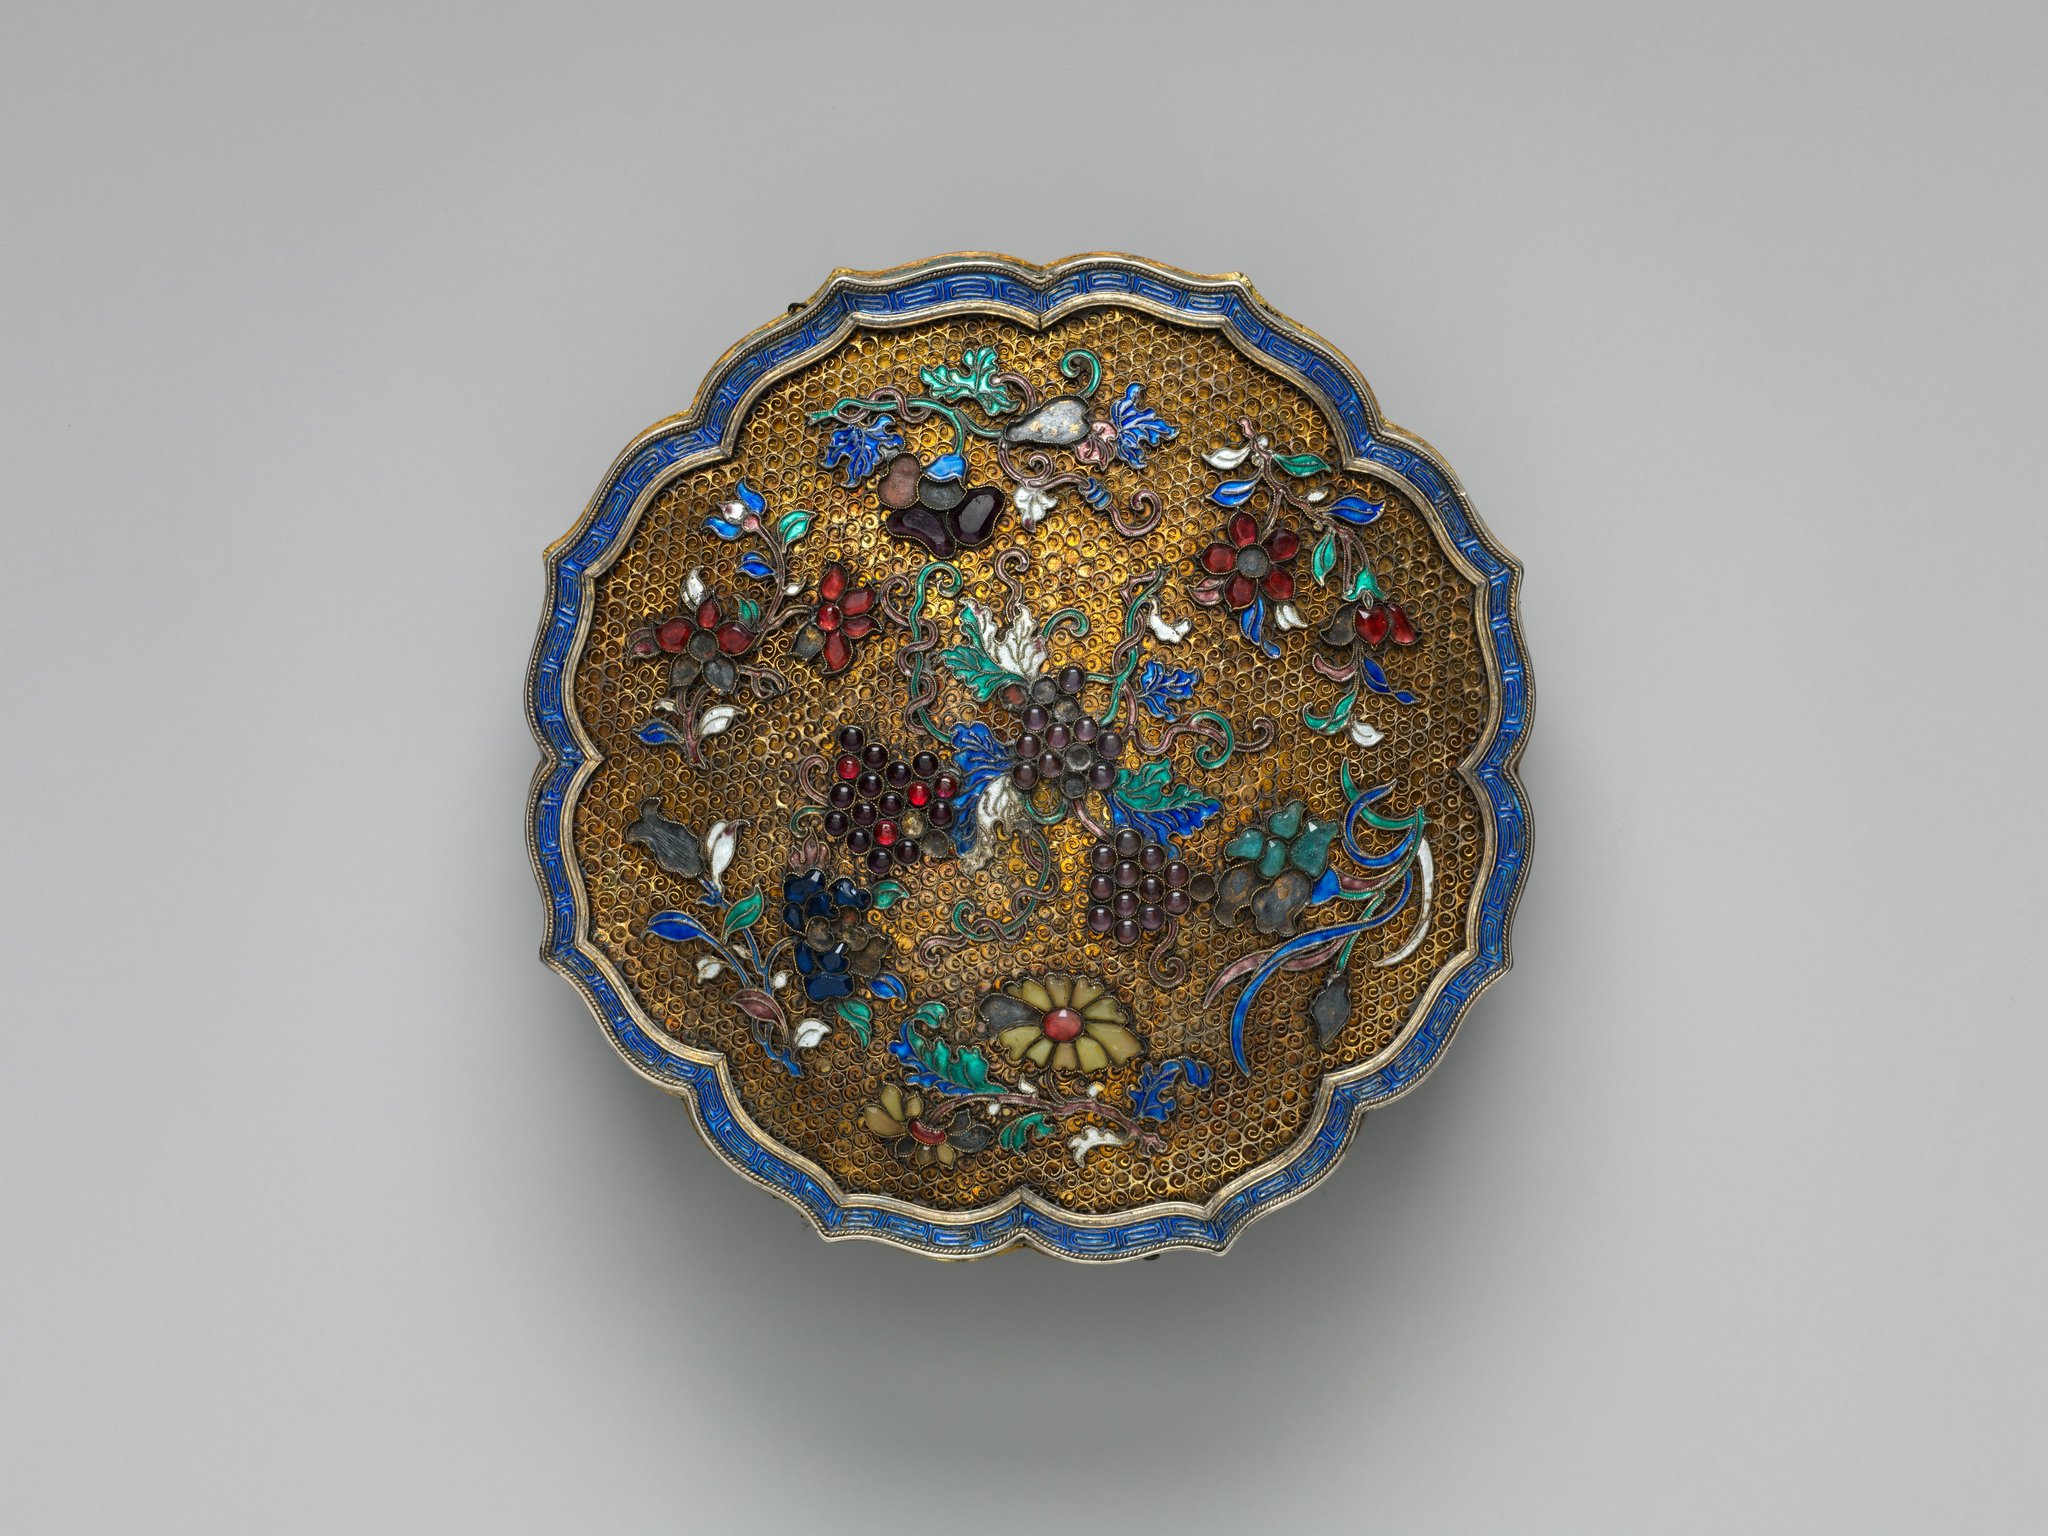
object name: covered box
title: Box in the shape of a flower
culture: chinese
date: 1767-1833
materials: enamel, gilt, silver, stone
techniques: enamel, painting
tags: flowers